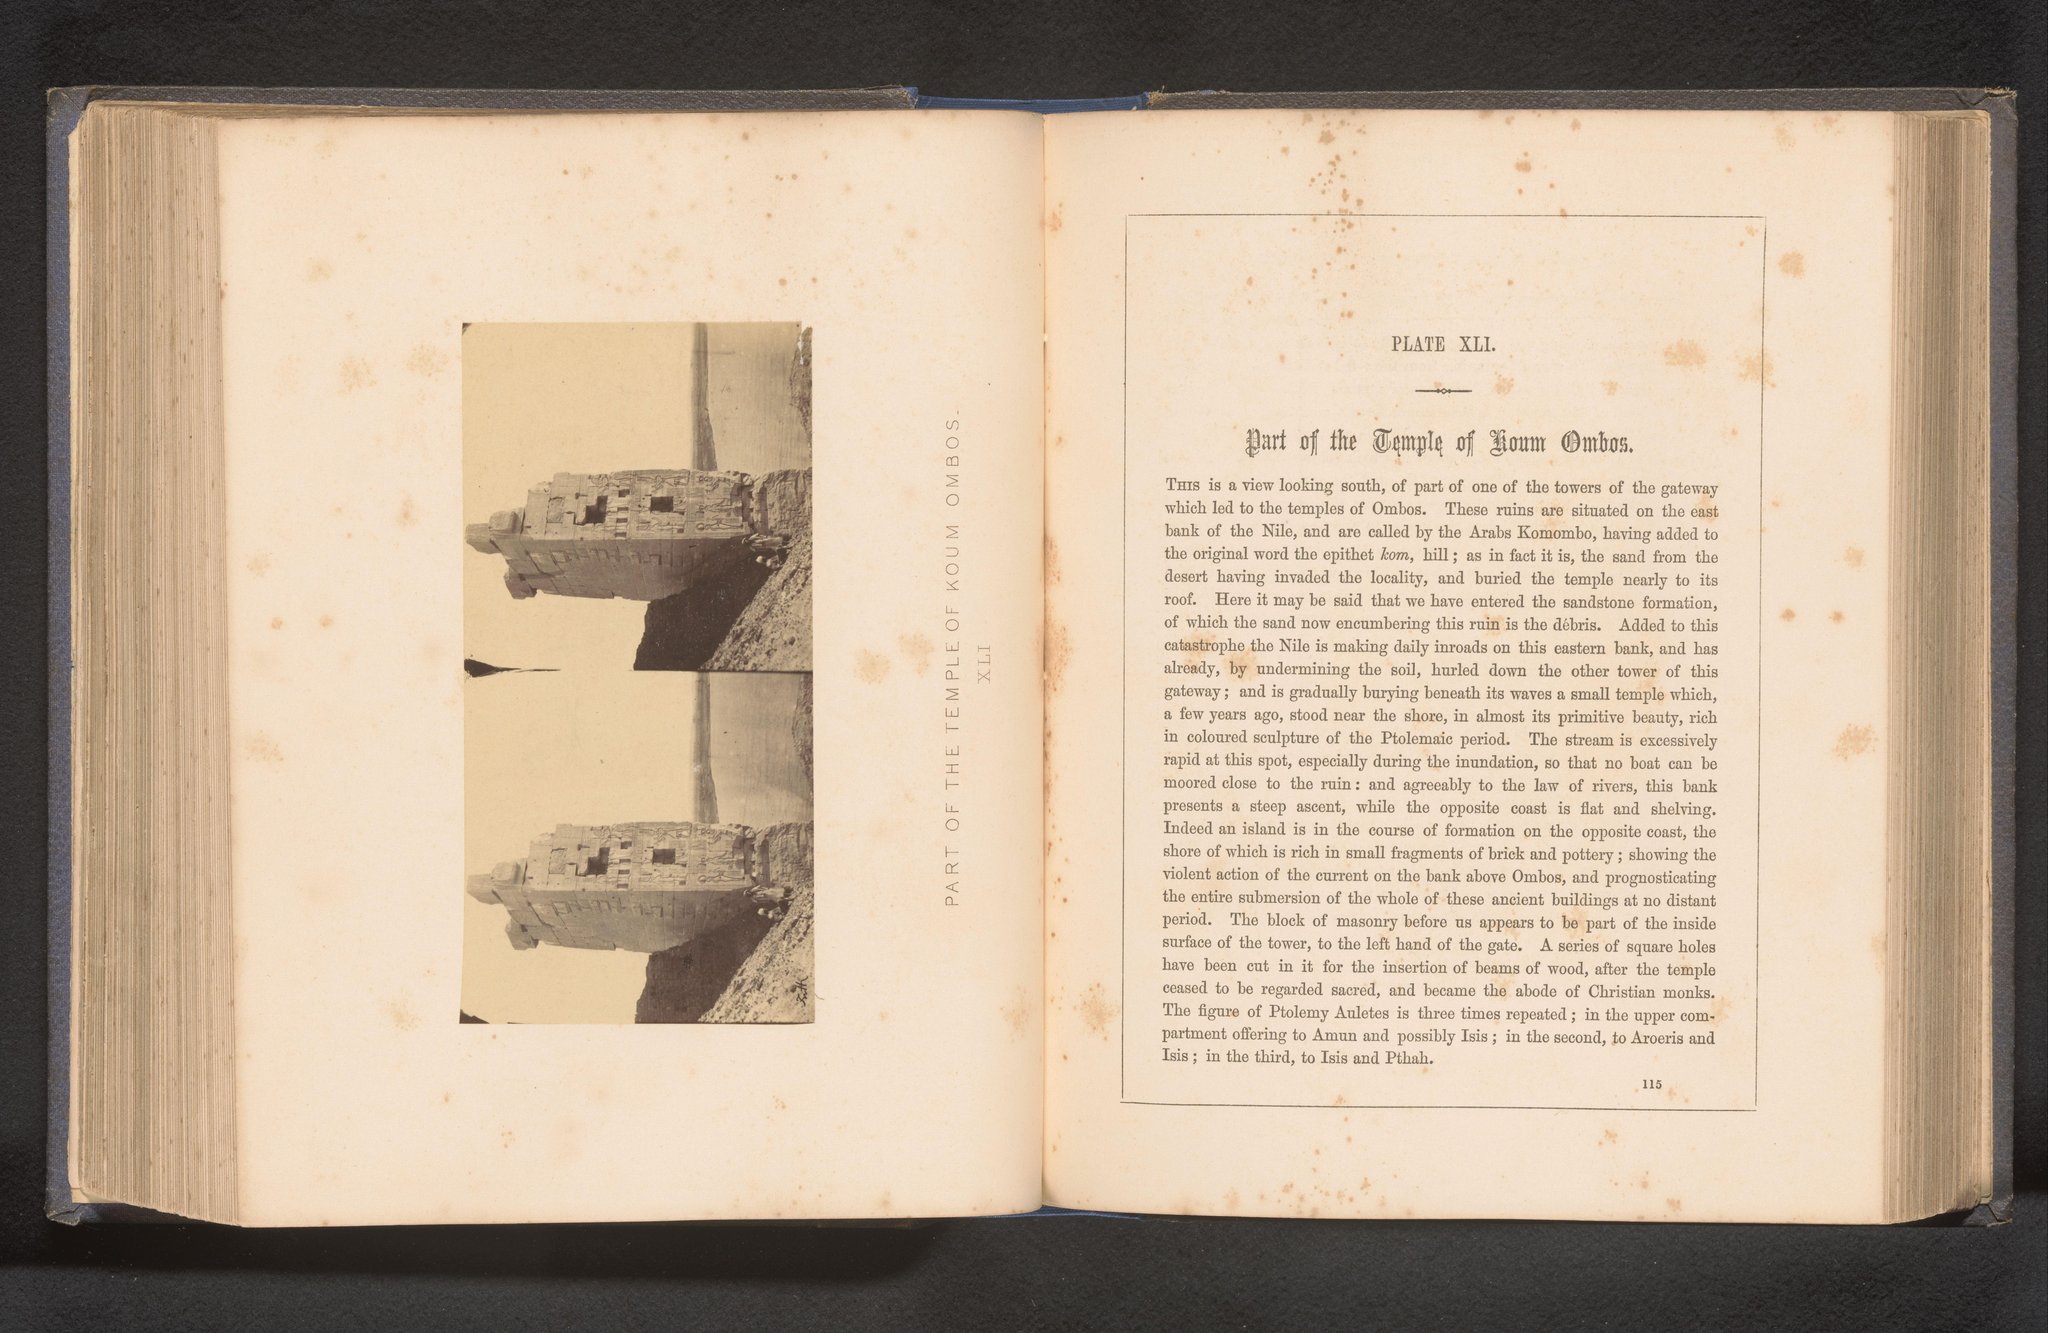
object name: stereograph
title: Ruïnes van de tempel van Kom Ombo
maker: francis frith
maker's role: publisher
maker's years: 1822-1898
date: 1857-1862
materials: photographic support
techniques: albumen print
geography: kom ombo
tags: temple, shrine ~ egyptian religion, ruin of a building ~ architecture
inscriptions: number: ‘XLI’, name: ‘Frith’